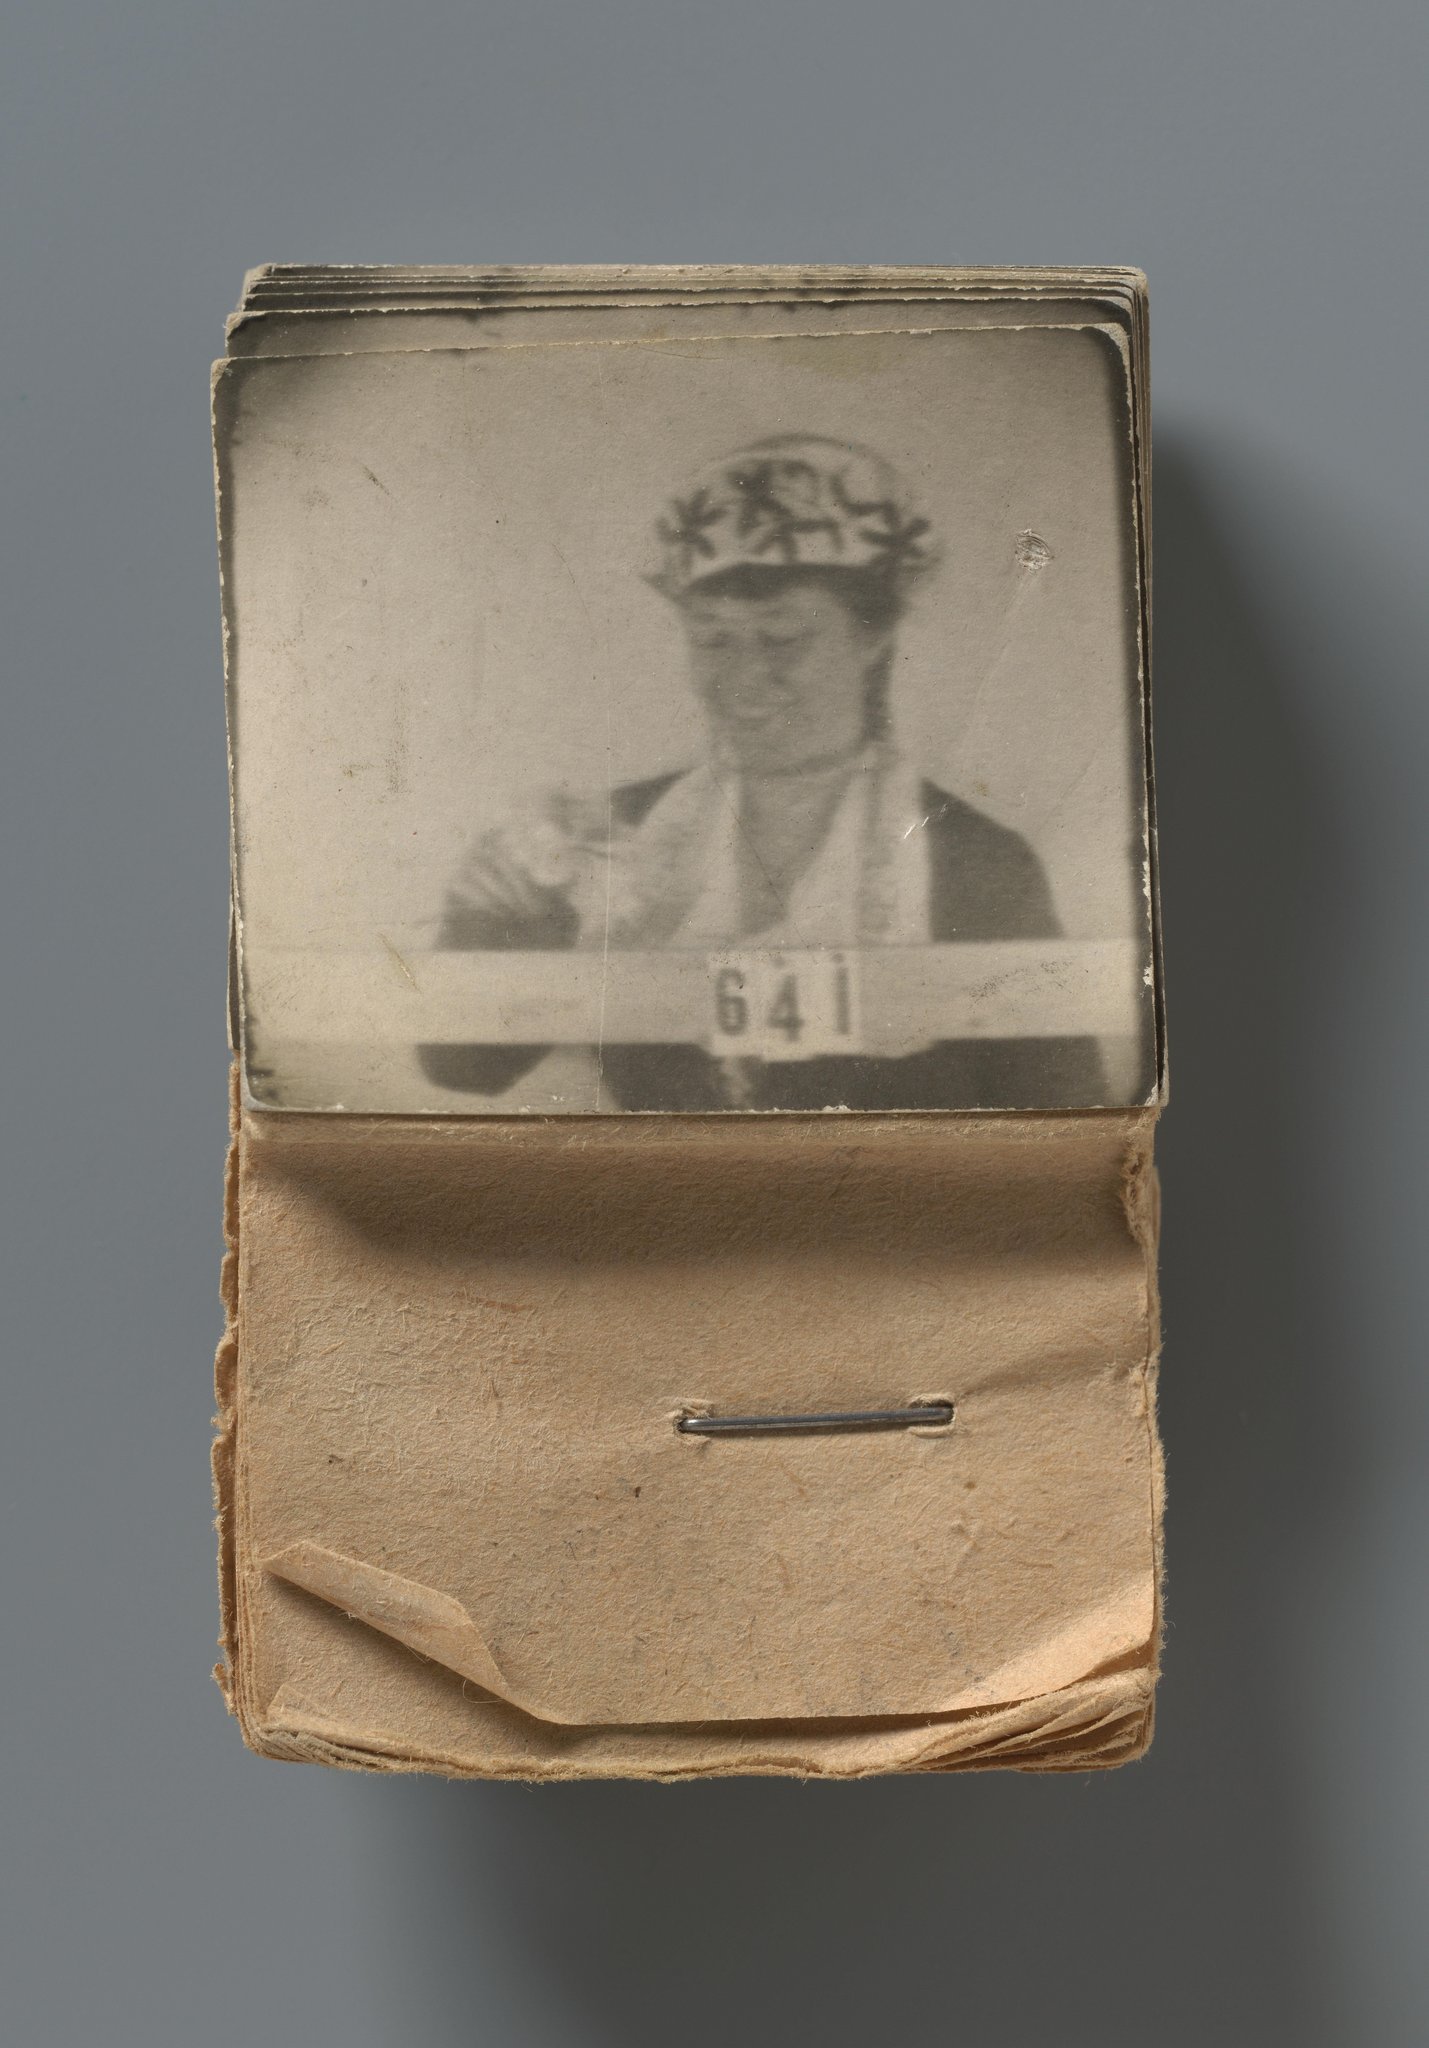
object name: fotosequentie, pocketcinema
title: Vrouw ruikt aan een bloem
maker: Anonymous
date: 1910-1930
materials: paper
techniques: gelatin silver print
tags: cut flowers; nosegay, bunch of flowers, adult woman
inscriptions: number: ‘641’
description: Fotosequentie als folioscoop met een vrouw die aan een bloem ruikt.